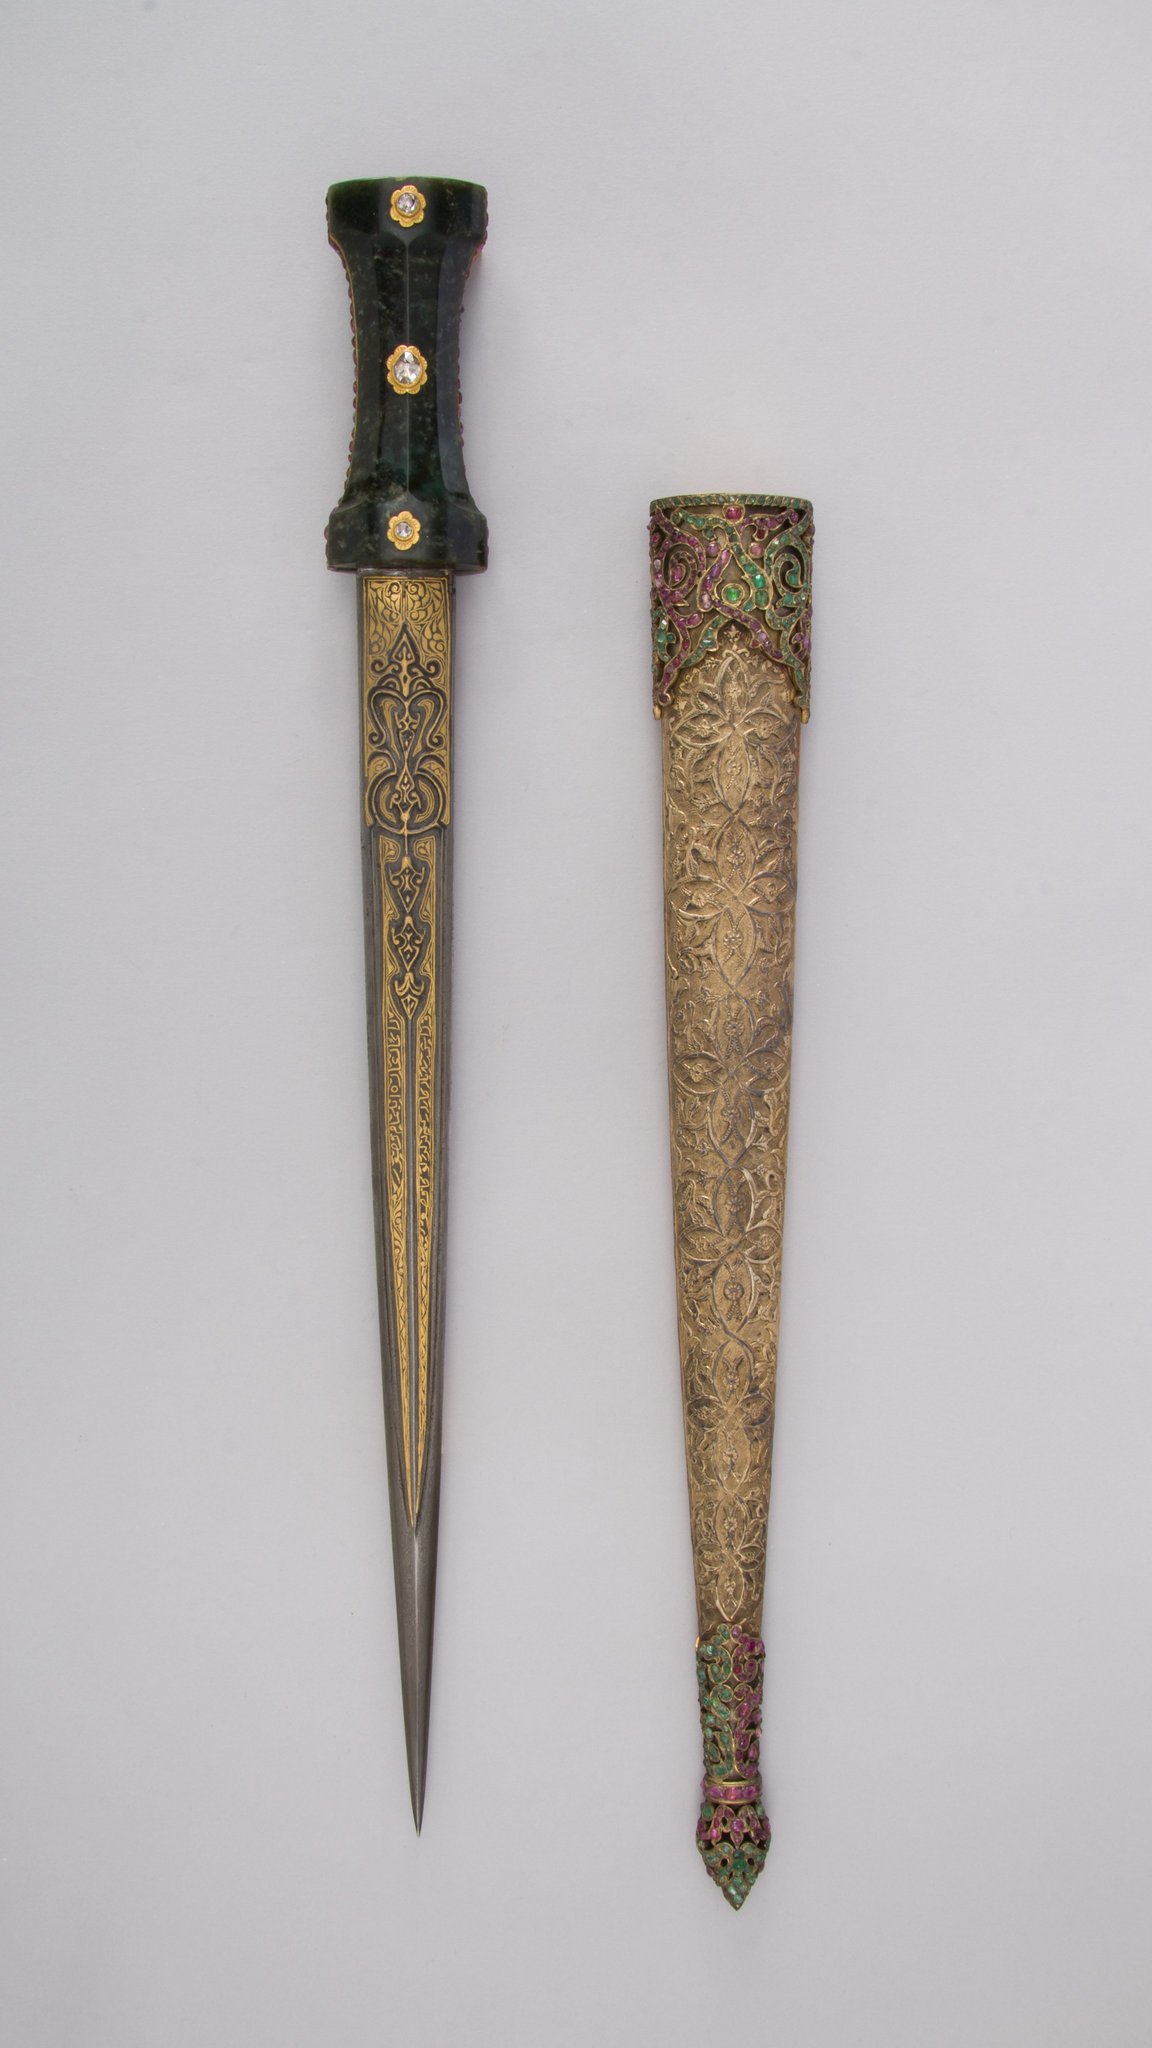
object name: dagger with sheath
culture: turkish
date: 1801-1900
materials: diamond, gemstone, gold, jade, steel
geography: ottoman empire